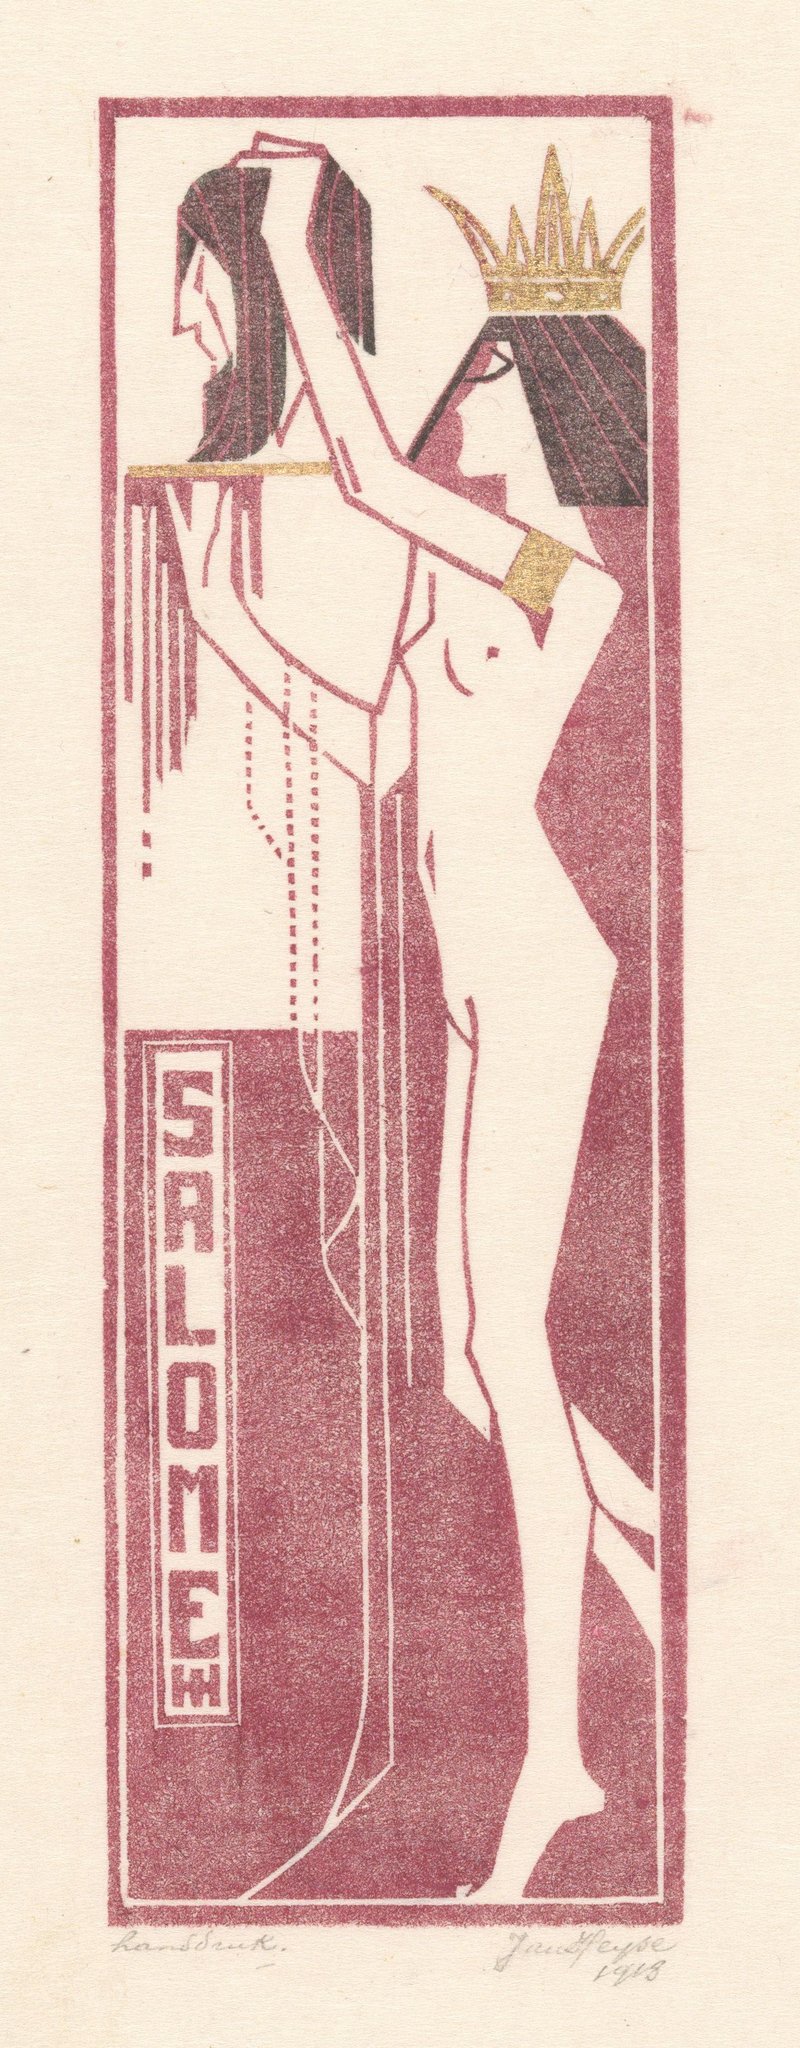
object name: print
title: Salomé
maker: jan heyse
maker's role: painter, print maker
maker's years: 1882-1954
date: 1918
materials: paper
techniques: woodcut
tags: salome with the head of john the baptist on a dish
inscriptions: collector's mark: Lugt 2228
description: Een naakte Salomé met een kroon op het hoofd. In haar linkerhand houdt zij het hoofd van Johannes de Doper; in haar rechterhand een bord.